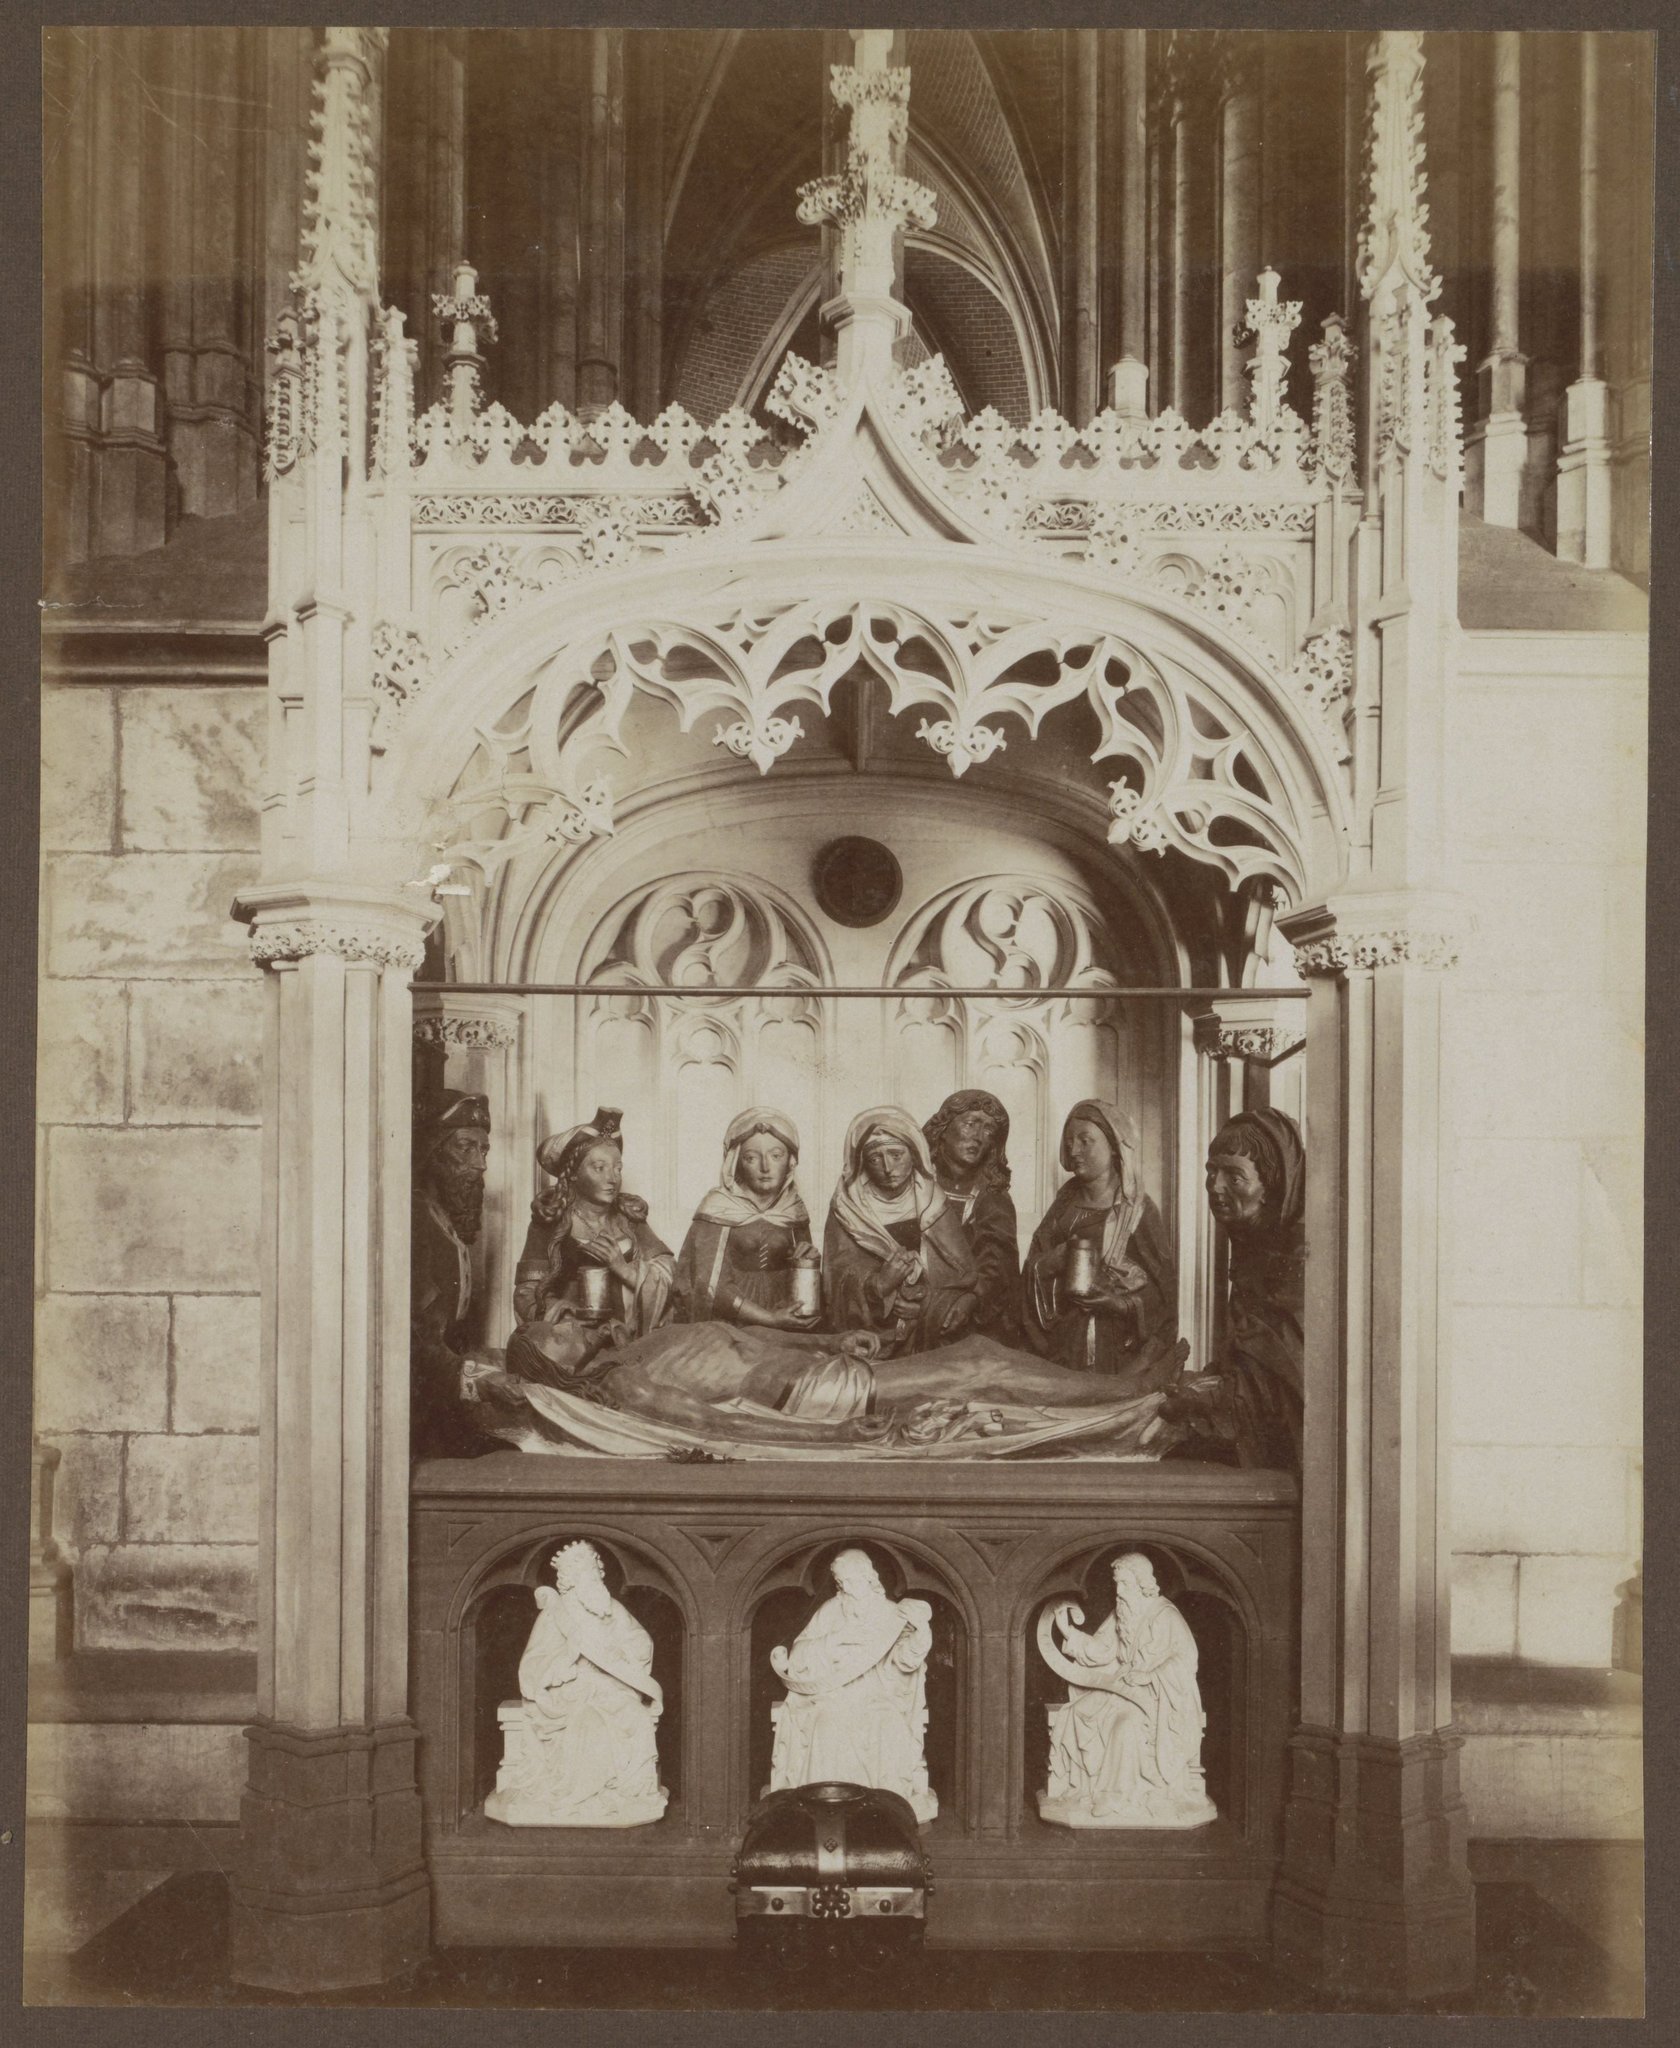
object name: photograph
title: Kruiswegstatie 14 in de Dom van Keulen (De graflegging van Christus)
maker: Anonymous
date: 1880-1900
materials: paper, photographic support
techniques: albumen print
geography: cologne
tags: the 14 franciscan stations of the cross (14), sculpture (+ relief ~ sculpture), cologne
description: Onderdeel van Reisalbum met foto's van Duitsland, Zwitserland, het Suezkanaal en Nederlands-Indië.